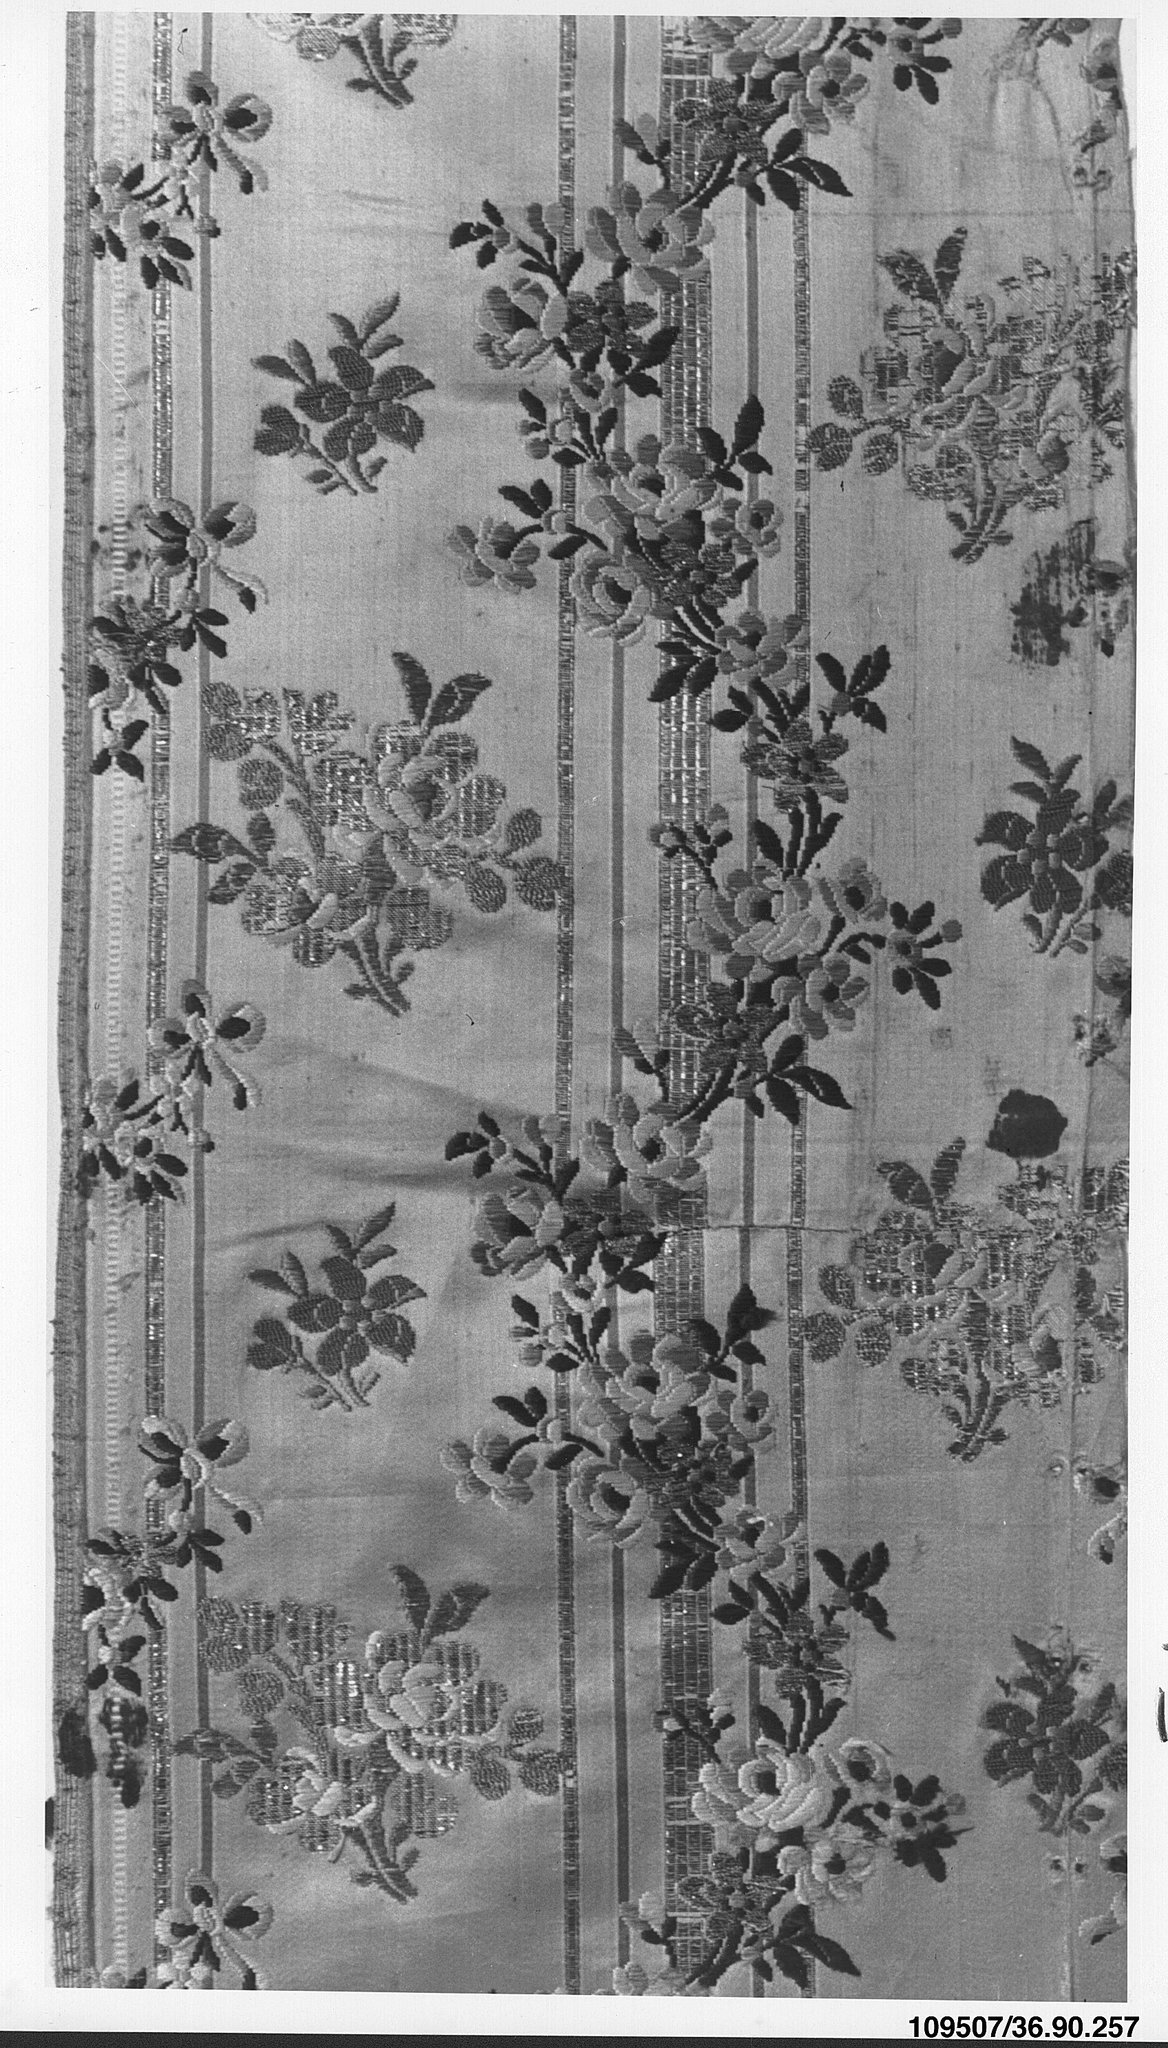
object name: piece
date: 1701-1800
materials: metal thread, silk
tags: flowers,leaves